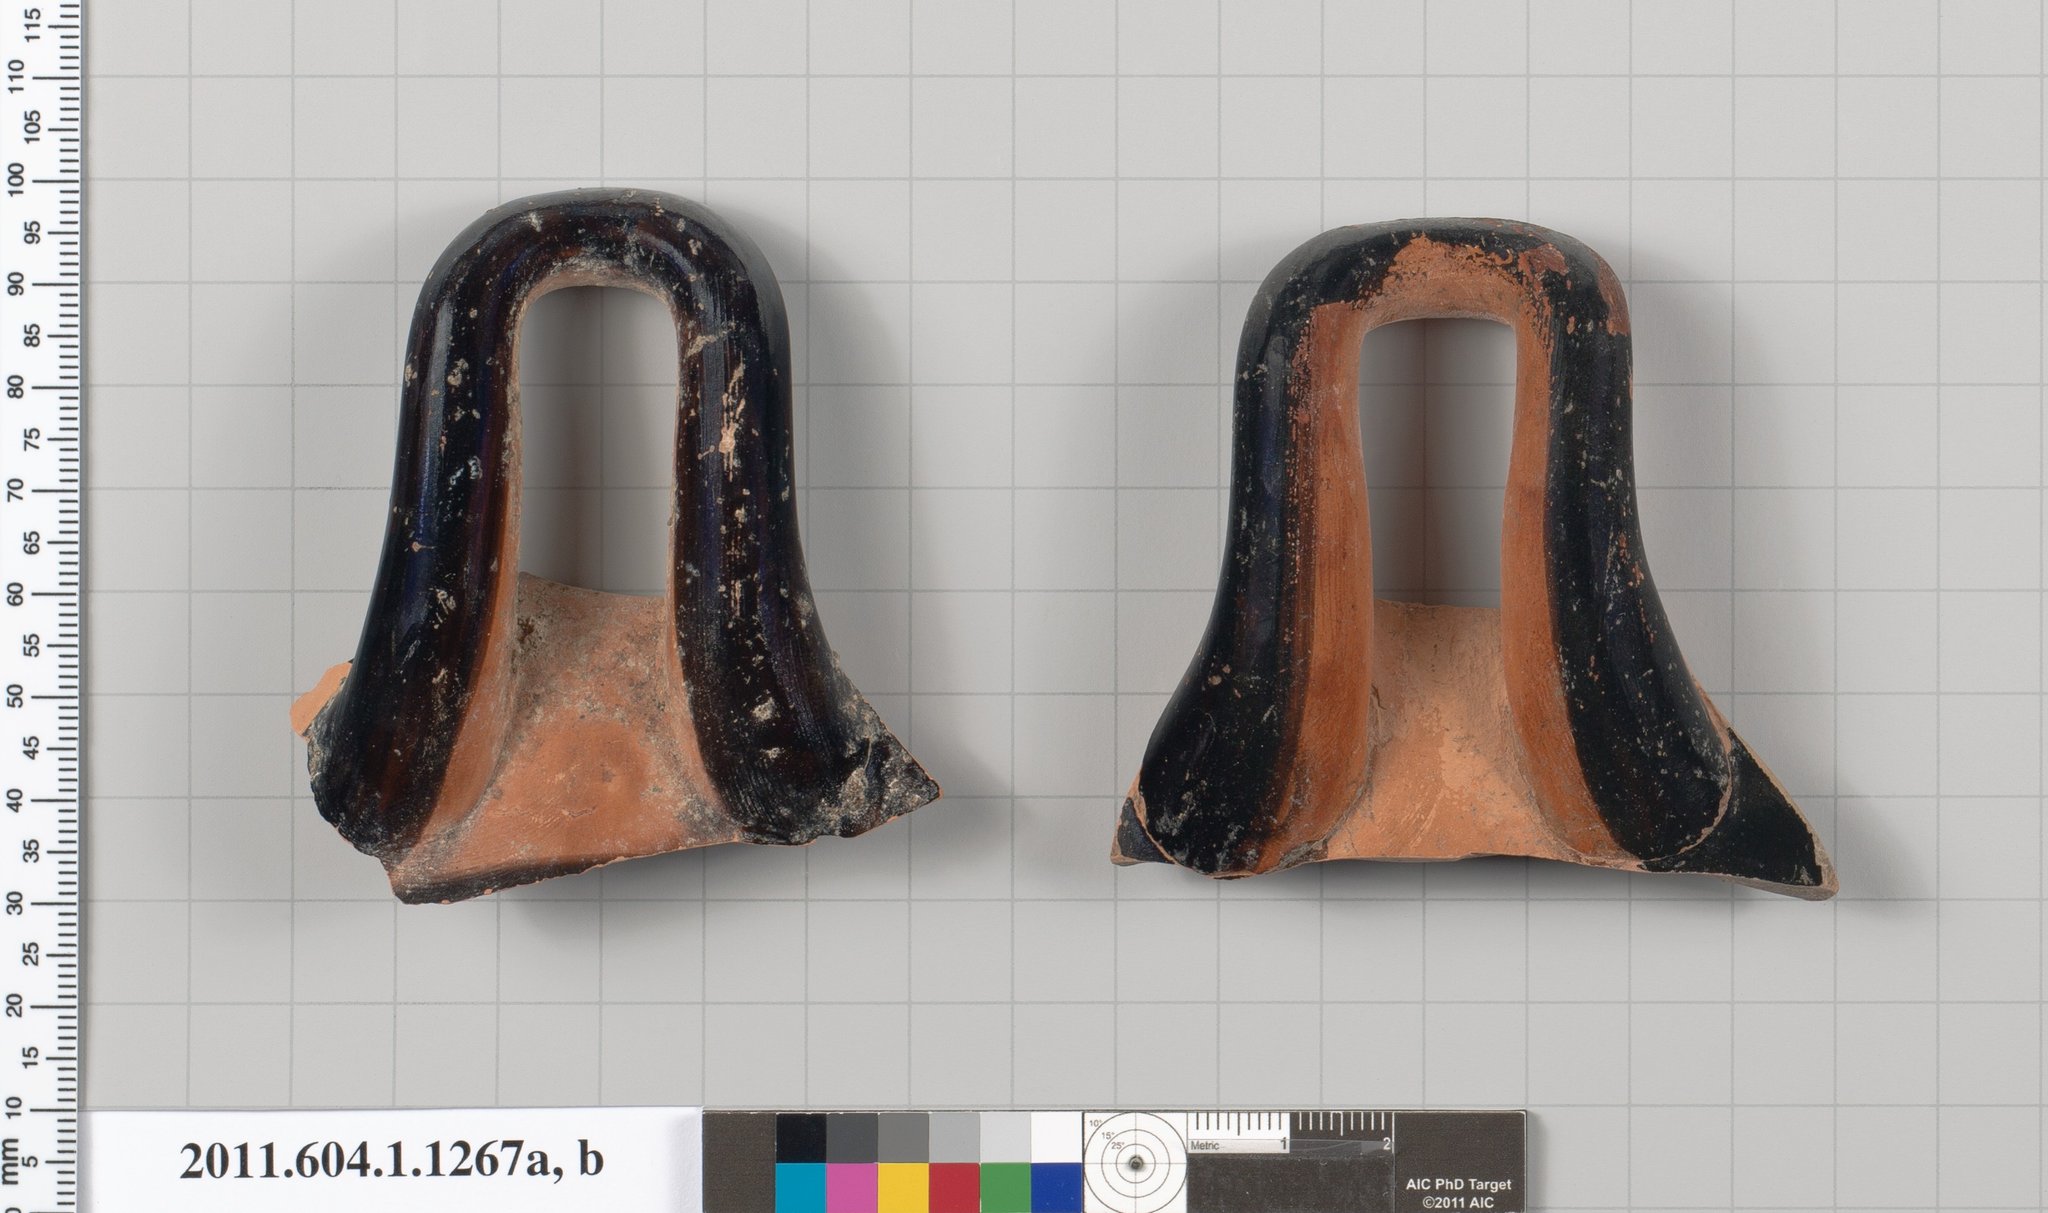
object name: kylix fragment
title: Terracotta fragments of kylikes (drinking cups)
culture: greek, attic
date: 500-401 BCE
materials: terracotta